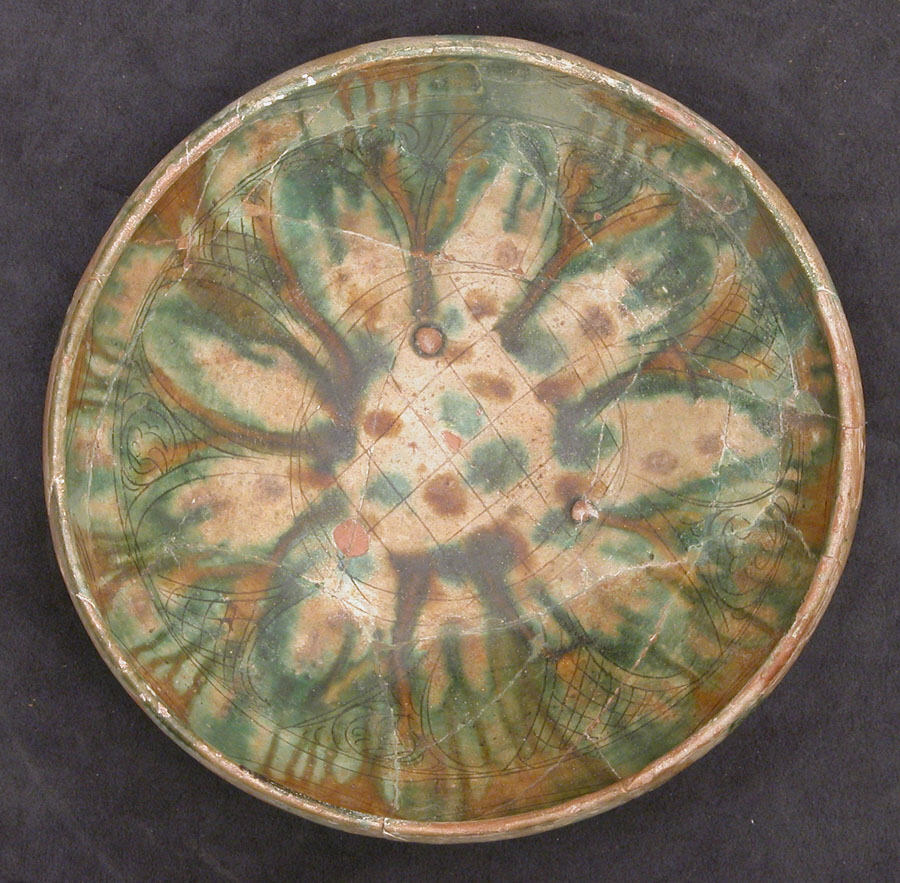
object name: bowl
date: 801-1000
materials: earthenware, glaze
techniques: incising, polychrome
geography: iran